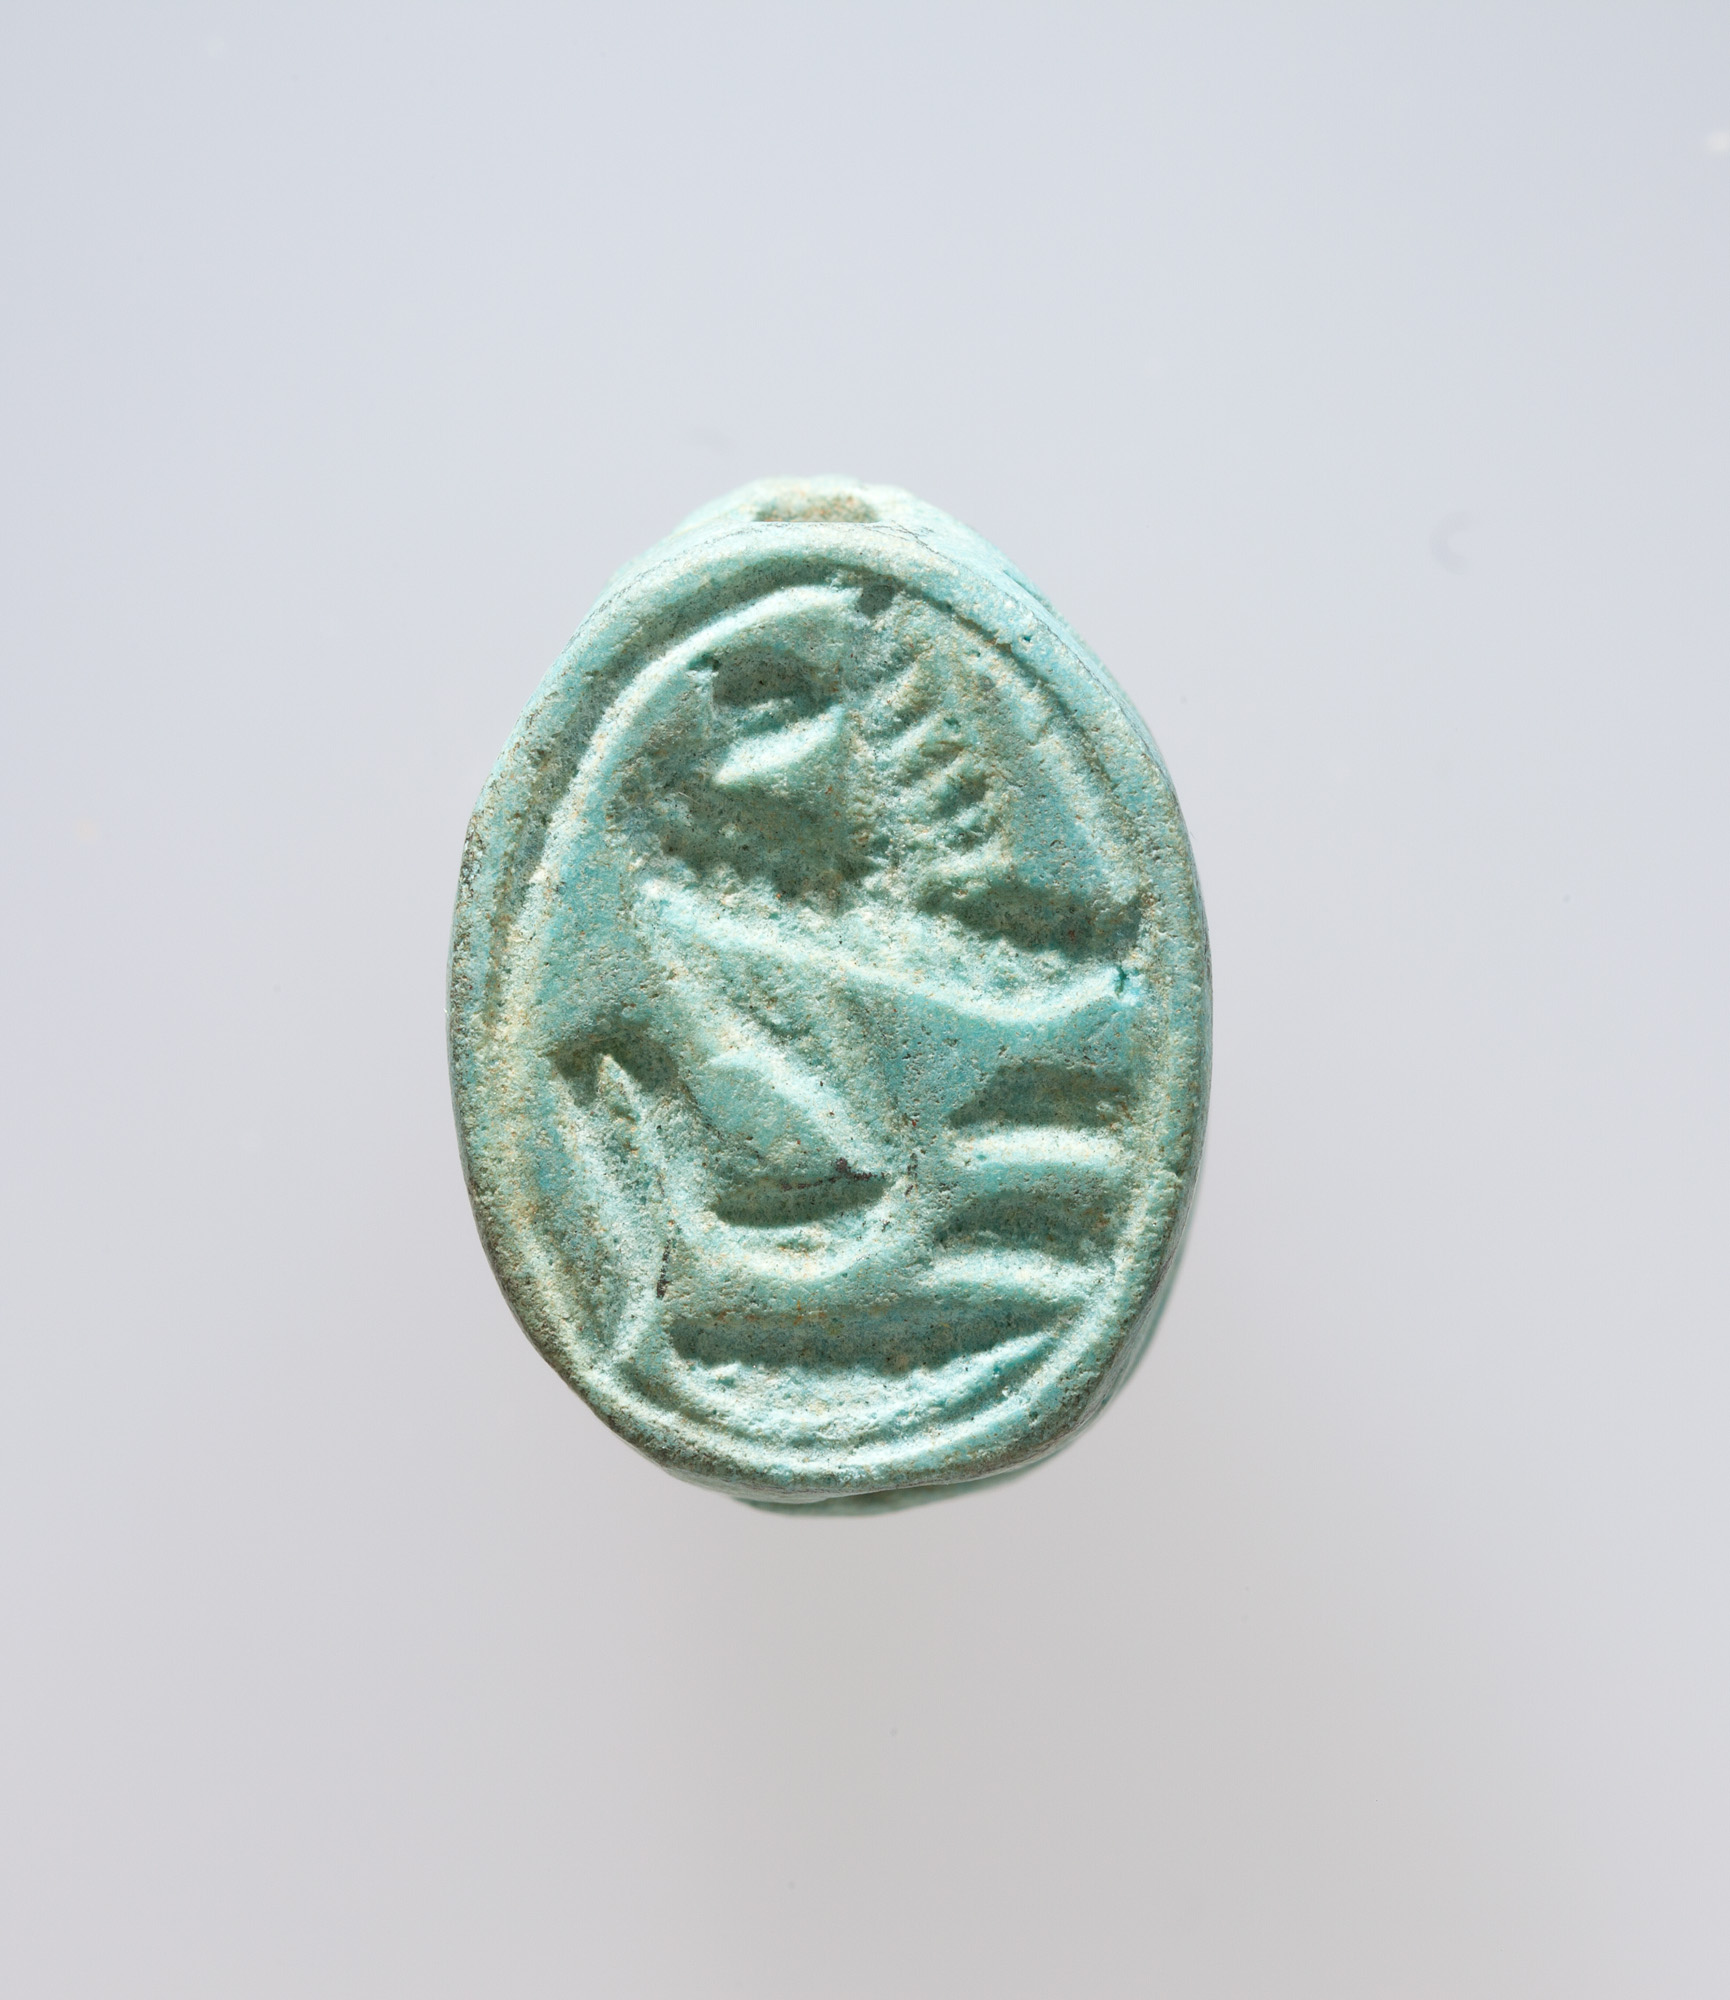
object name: scarab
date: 1479-1458 BCE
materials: faience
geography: egypt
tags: scarabs